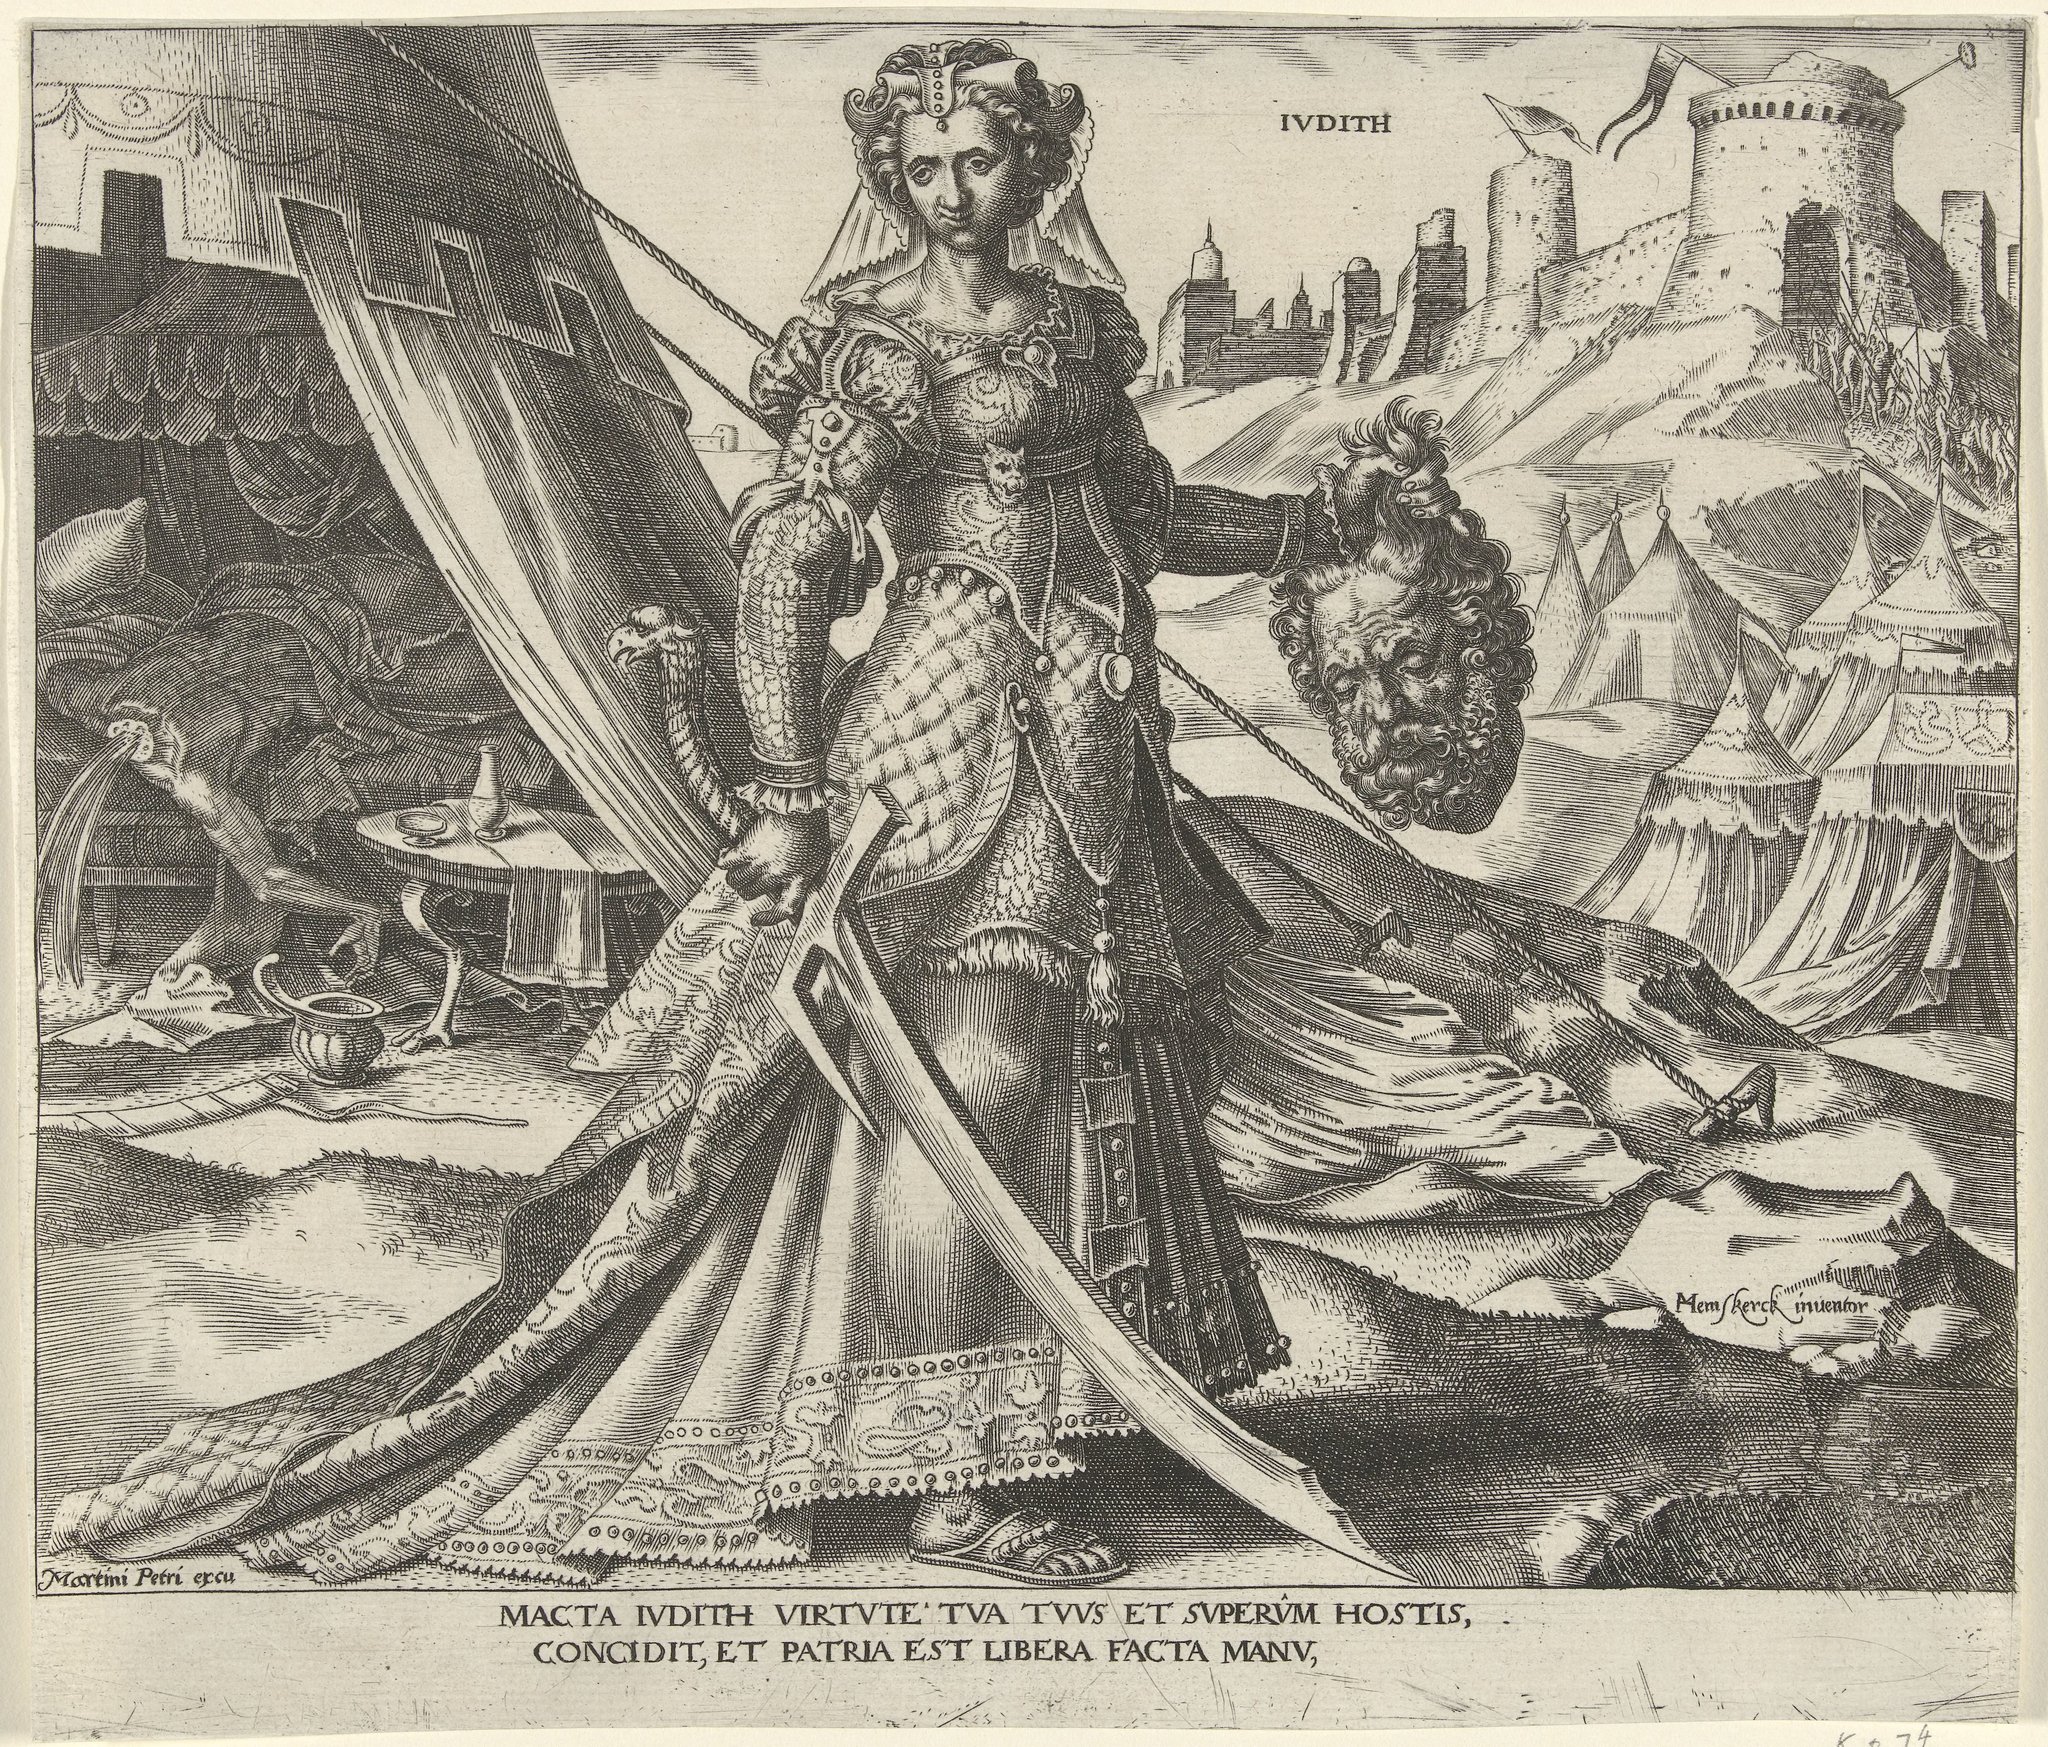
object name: print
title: Ivdith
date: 1560-1570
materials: paper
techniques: engraving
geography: antwerp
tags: female persons from the old testament (with name) (not in biblical context)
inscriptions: collector's mark: Lugt 2760, collector's mark: Lugt 2228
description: Judit met het hoofd van Holofernes, staand voor de tent van Holofernes. Vierde prent uit een serie van acht prenten met beroemde vrouwen uit het Oude en Nieuwe Testament.